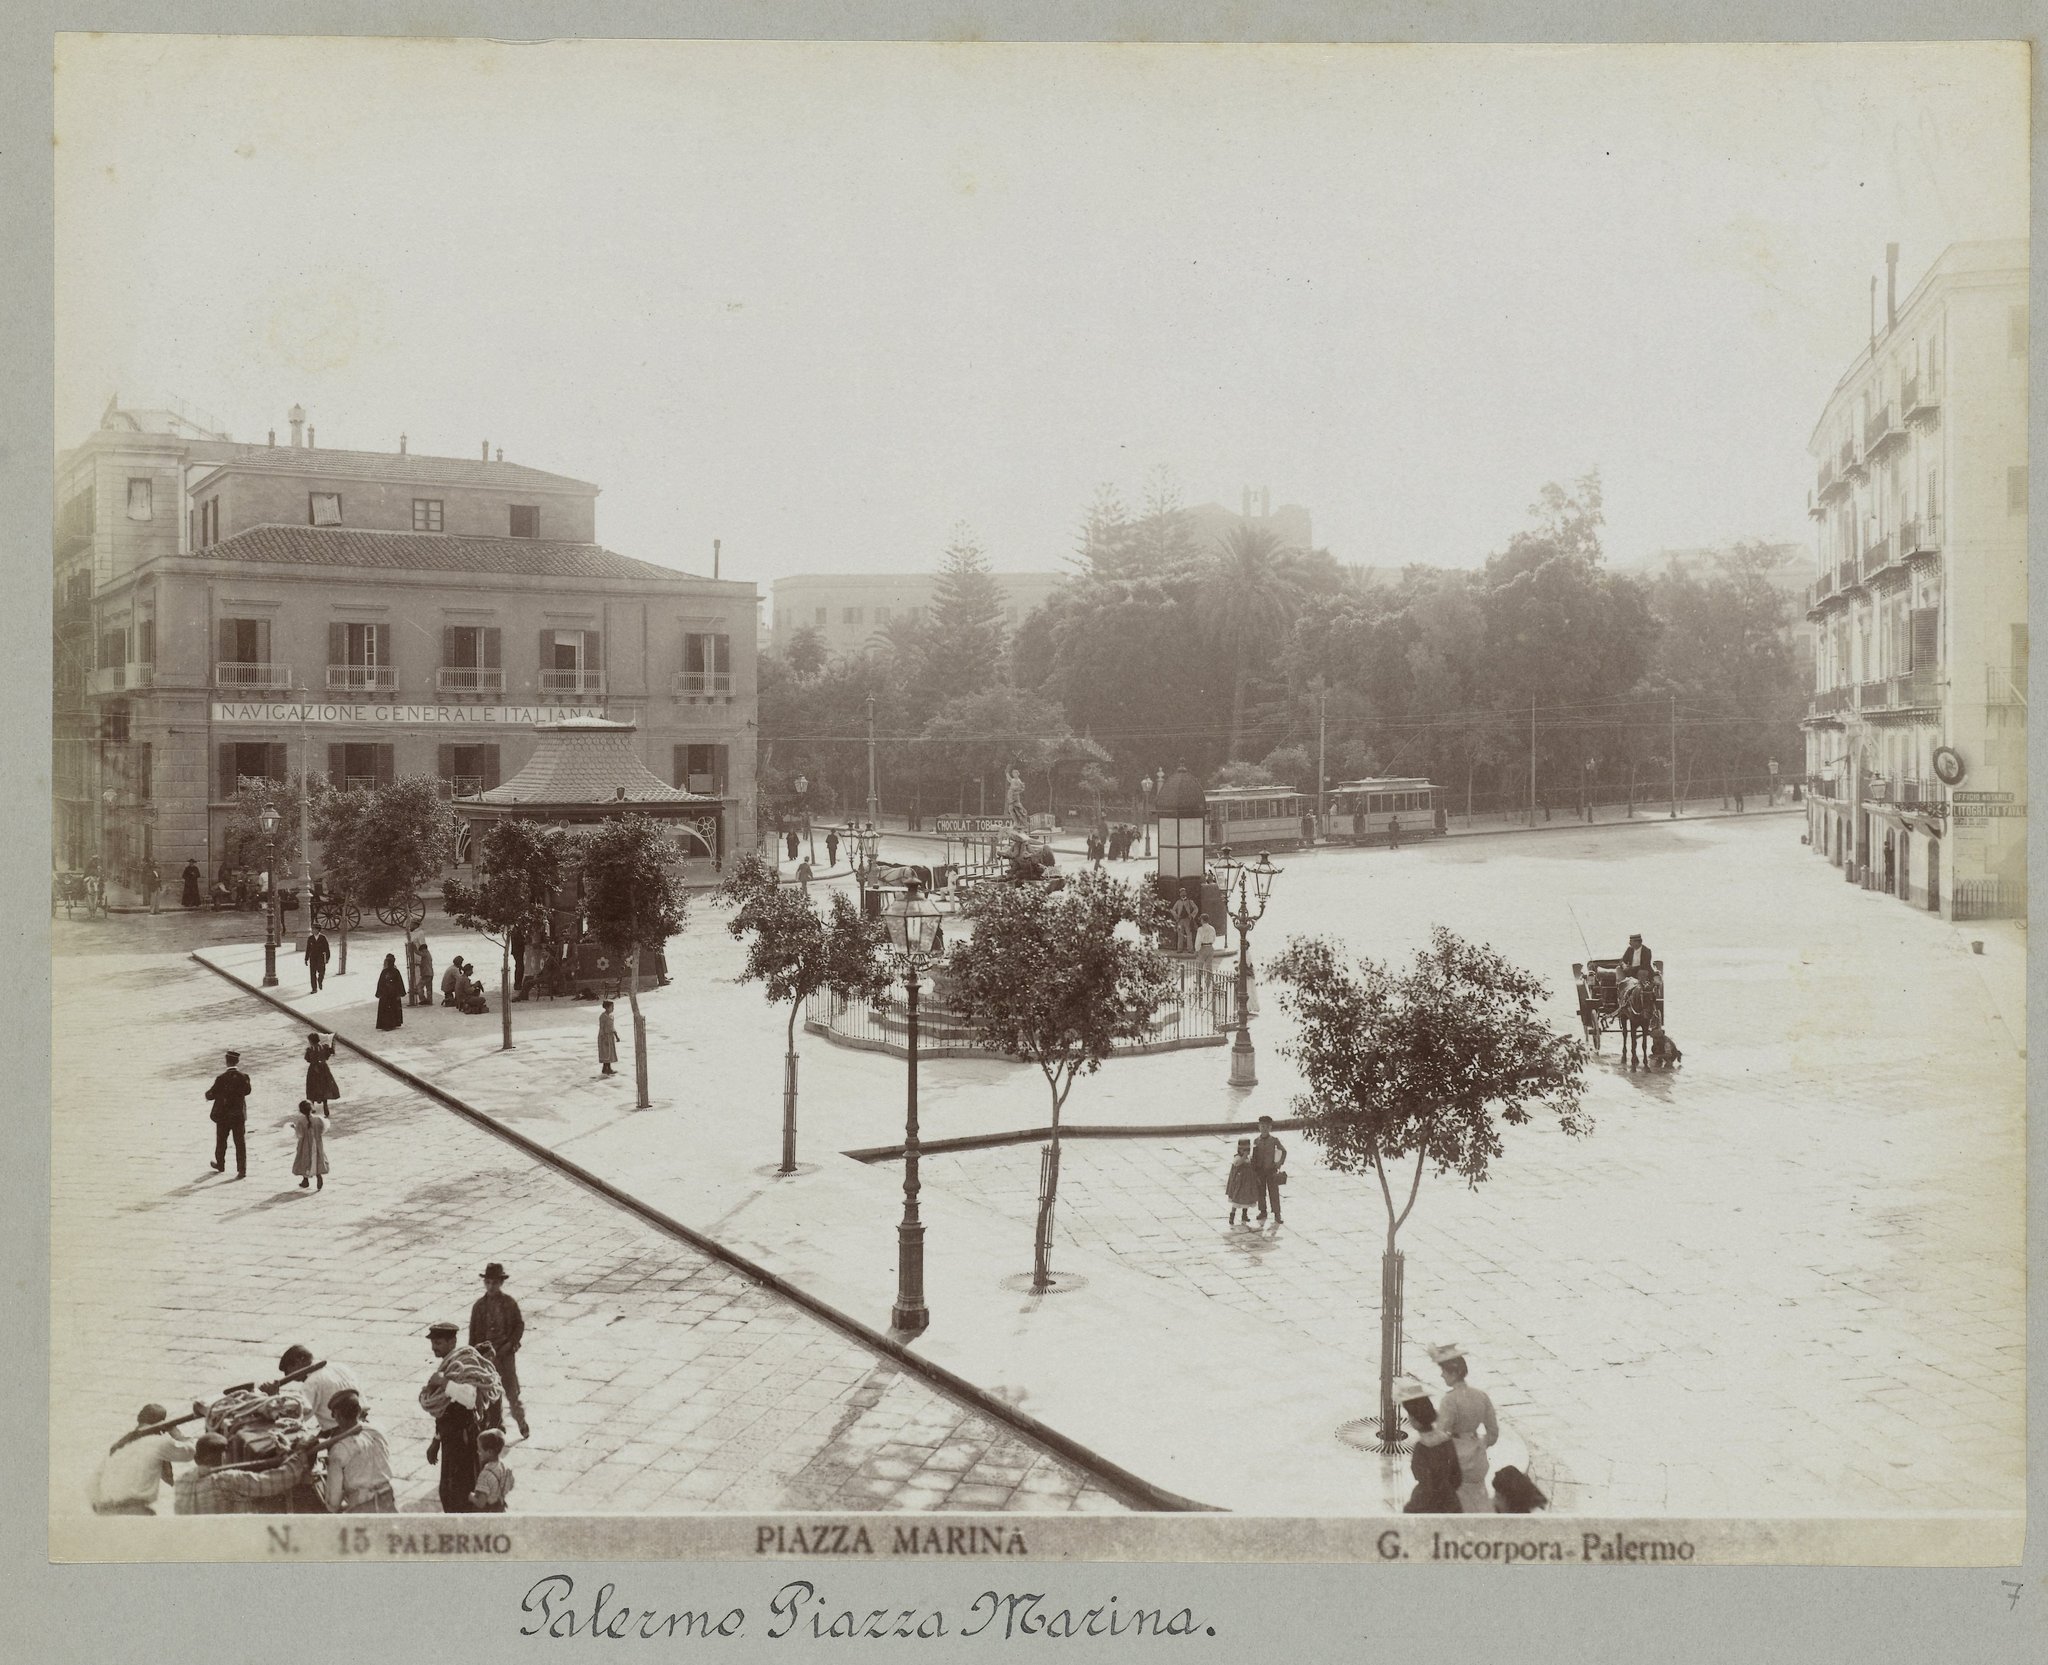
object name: photograph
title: N.15 Palermo, Piazza Marina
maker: giuseppe incorpora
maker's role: fotograaf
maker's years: 1834-1914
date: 1893-1903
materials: cardboard, photographic support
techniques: albumen print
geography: palermo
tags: palermo